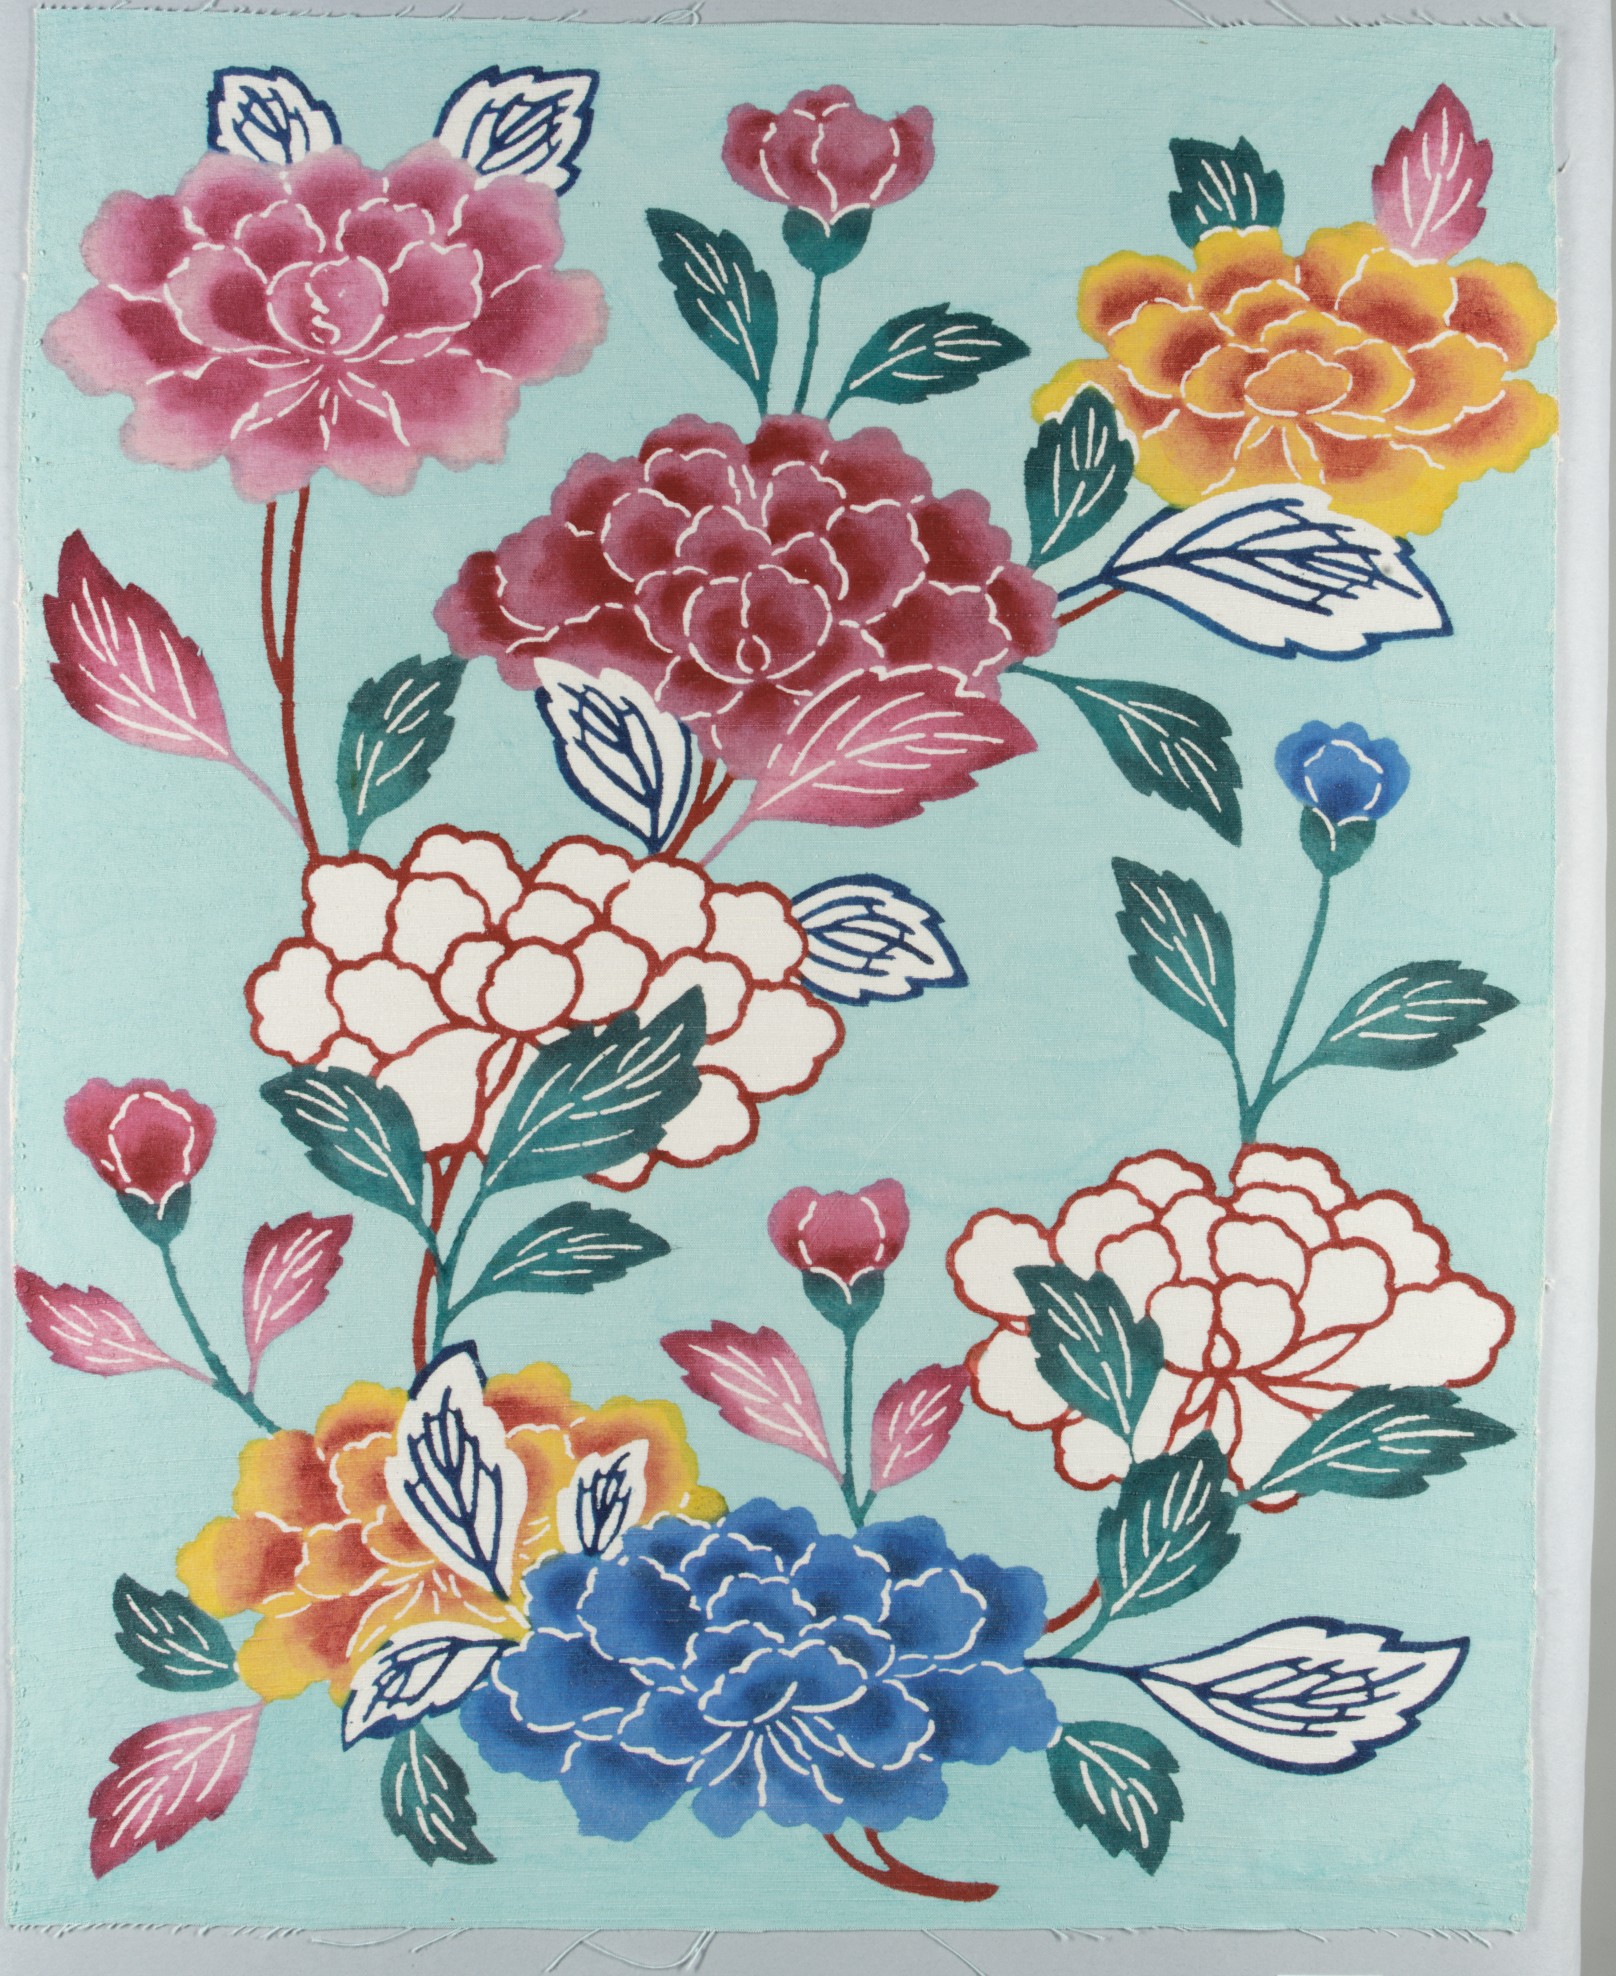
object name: bingata panel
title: Bingata Panel with Tree Peonies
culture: japanese or ryukyuan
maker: teruyo shinohara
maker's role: artist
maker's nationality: japanese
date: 1901-2000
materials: cotton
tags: peonies,leaves